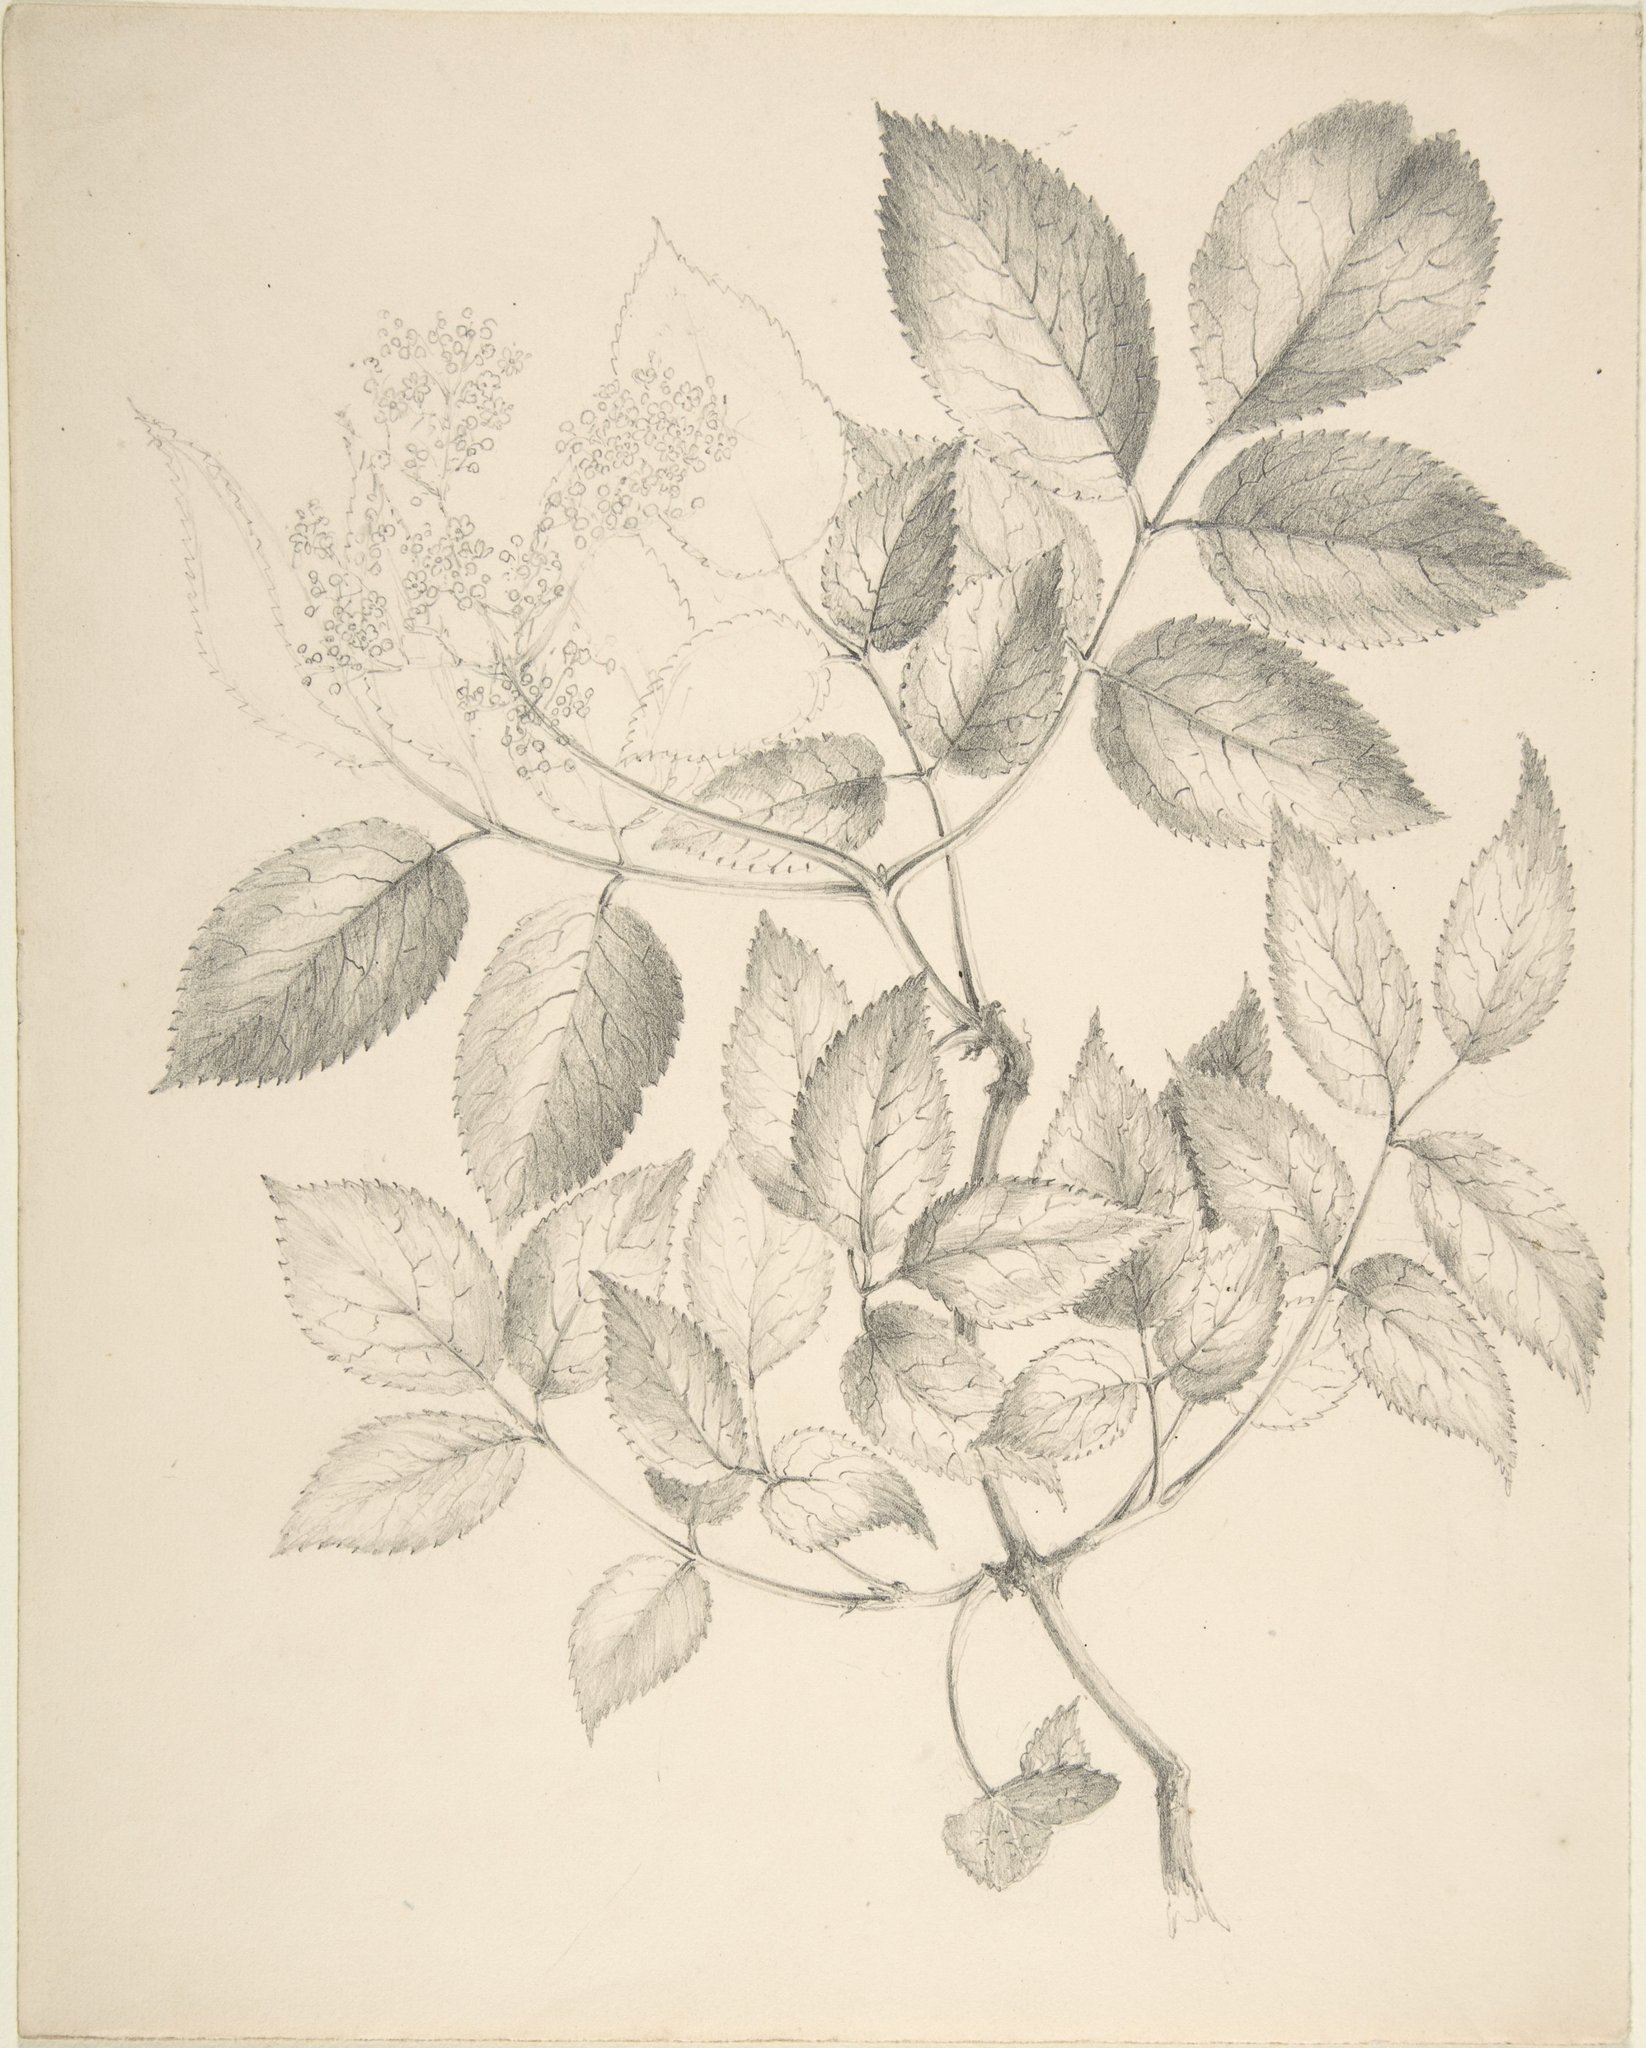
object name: drawing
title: Leaves and Flowers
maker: anonymous, british, 19th century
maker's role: artist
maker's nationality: british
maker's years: 1800-1900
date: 1801-1900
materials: graphite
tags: flowers,leaves